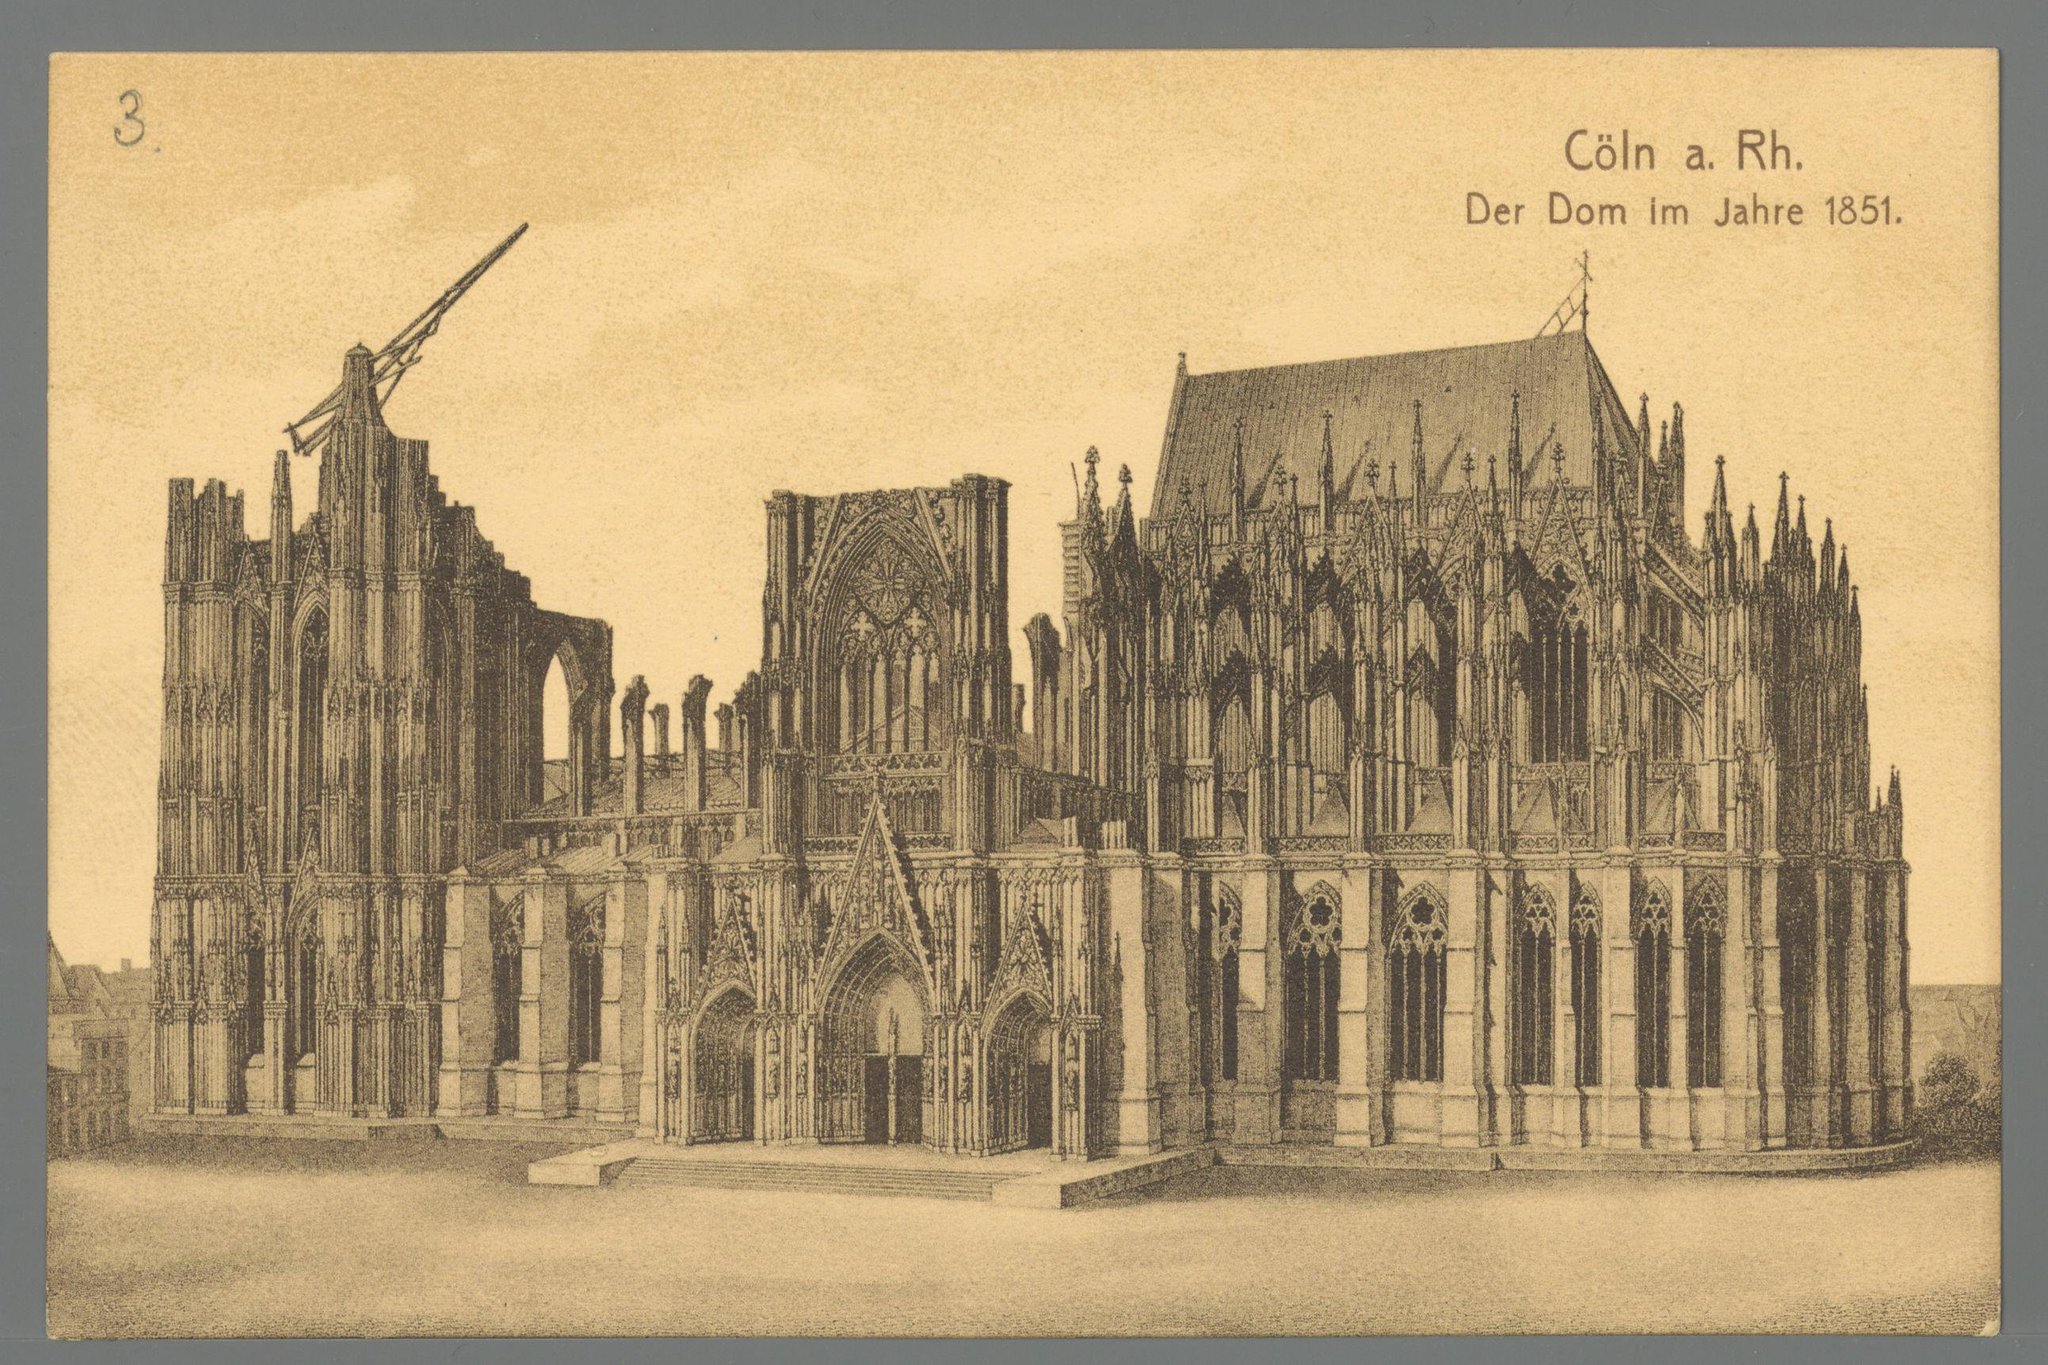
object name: ansichtkaart, prentbriefkaart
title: Cöln a. Rh. Der Dom im Jahre 1851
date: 1905-1930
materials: cardboard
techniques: photograph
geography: cologne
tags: church (exterior)